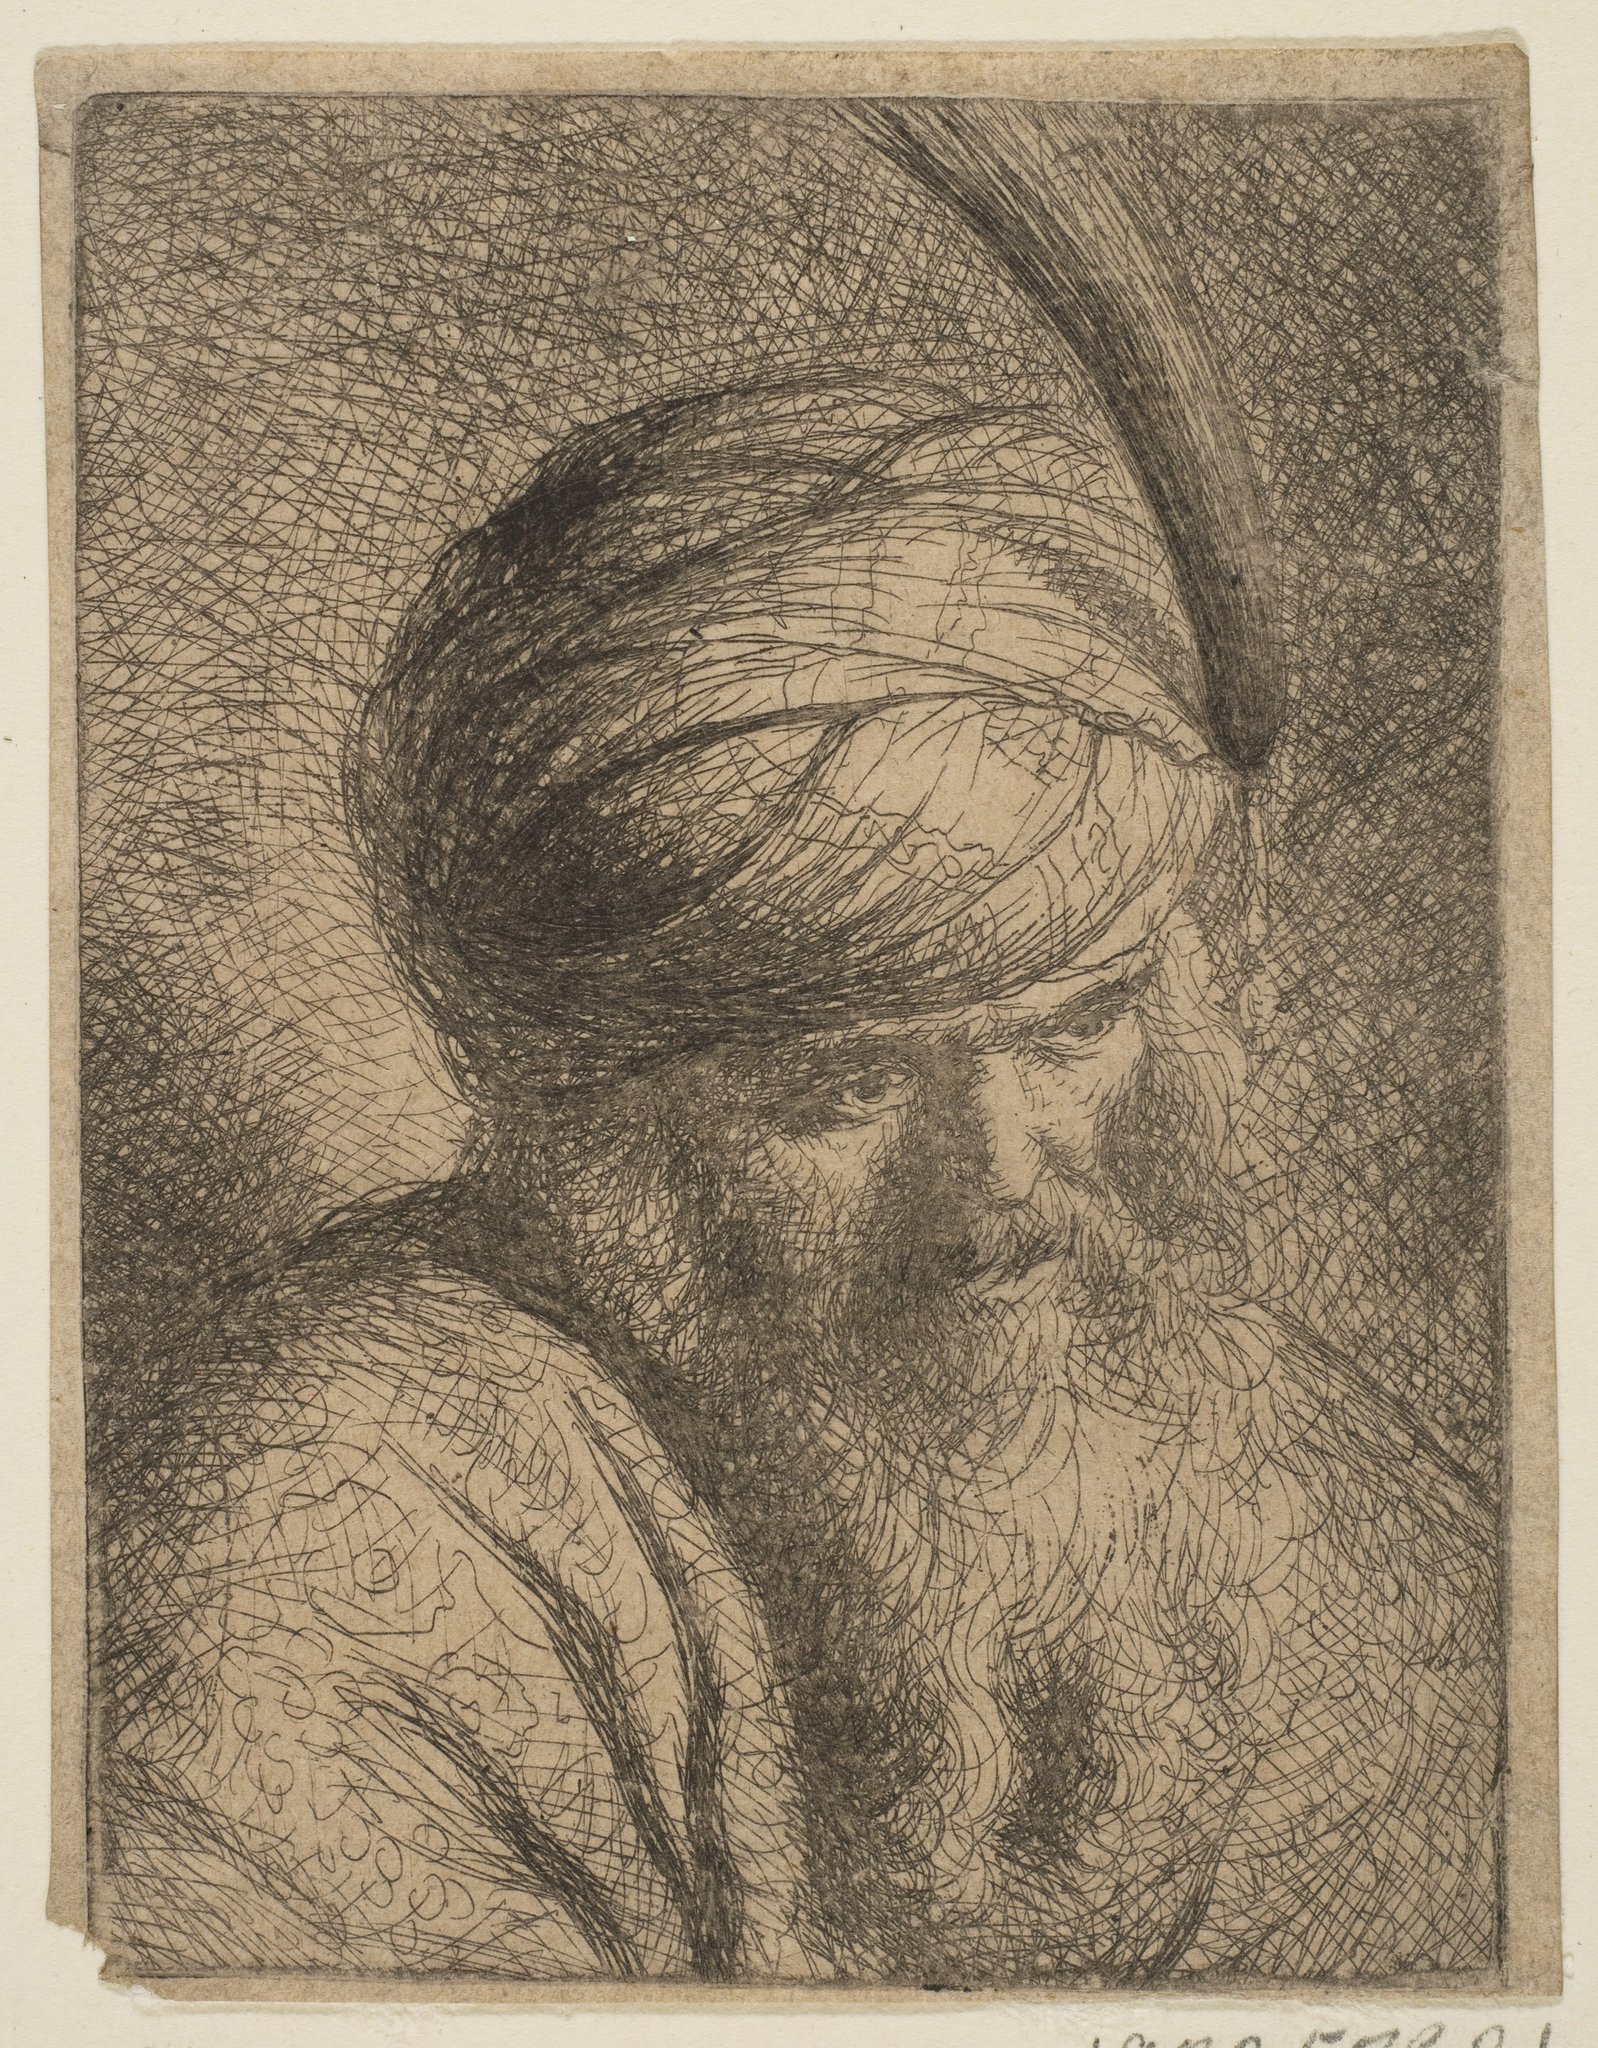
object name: print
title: Bust of a Man in a Feathered Turban and Long Beard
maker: rembrandt van rijn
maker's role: artist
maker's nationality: dutch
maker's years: 1606-1669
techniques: etching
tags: men